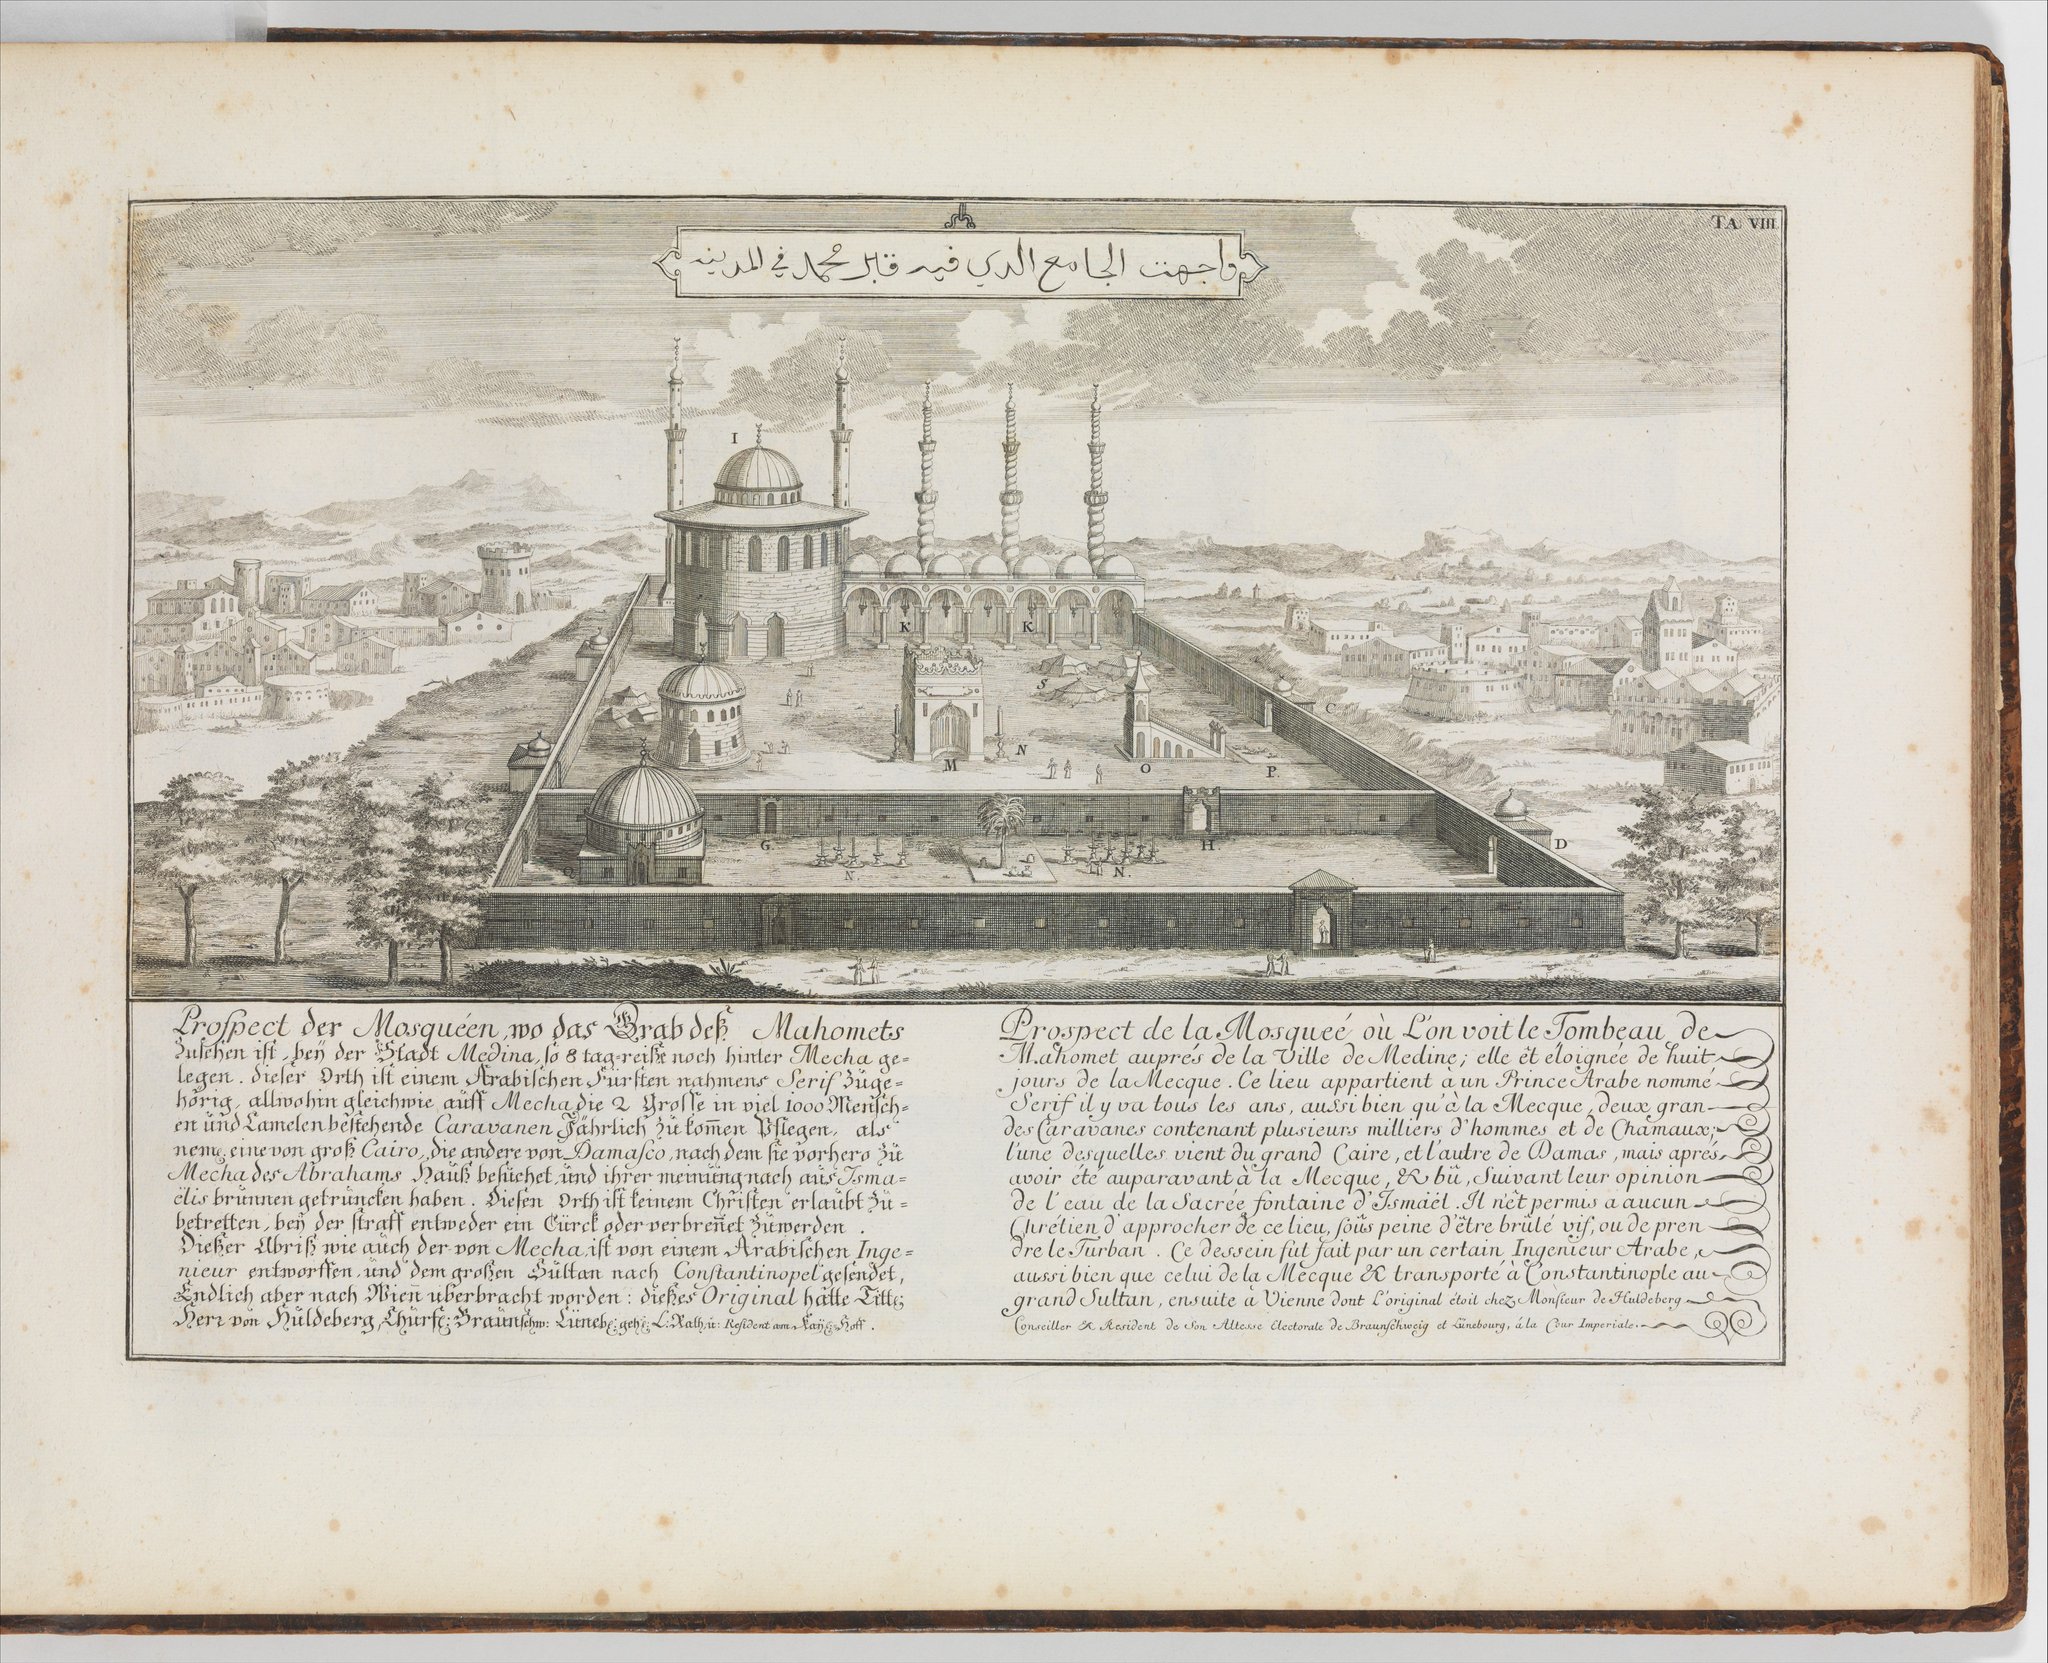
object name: book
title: Entwurff Einer Historischen Architectur (5 parts)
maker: johann bernhard fischer von erlach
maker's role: artist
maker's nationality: austrian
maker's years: 1656-1723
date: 1725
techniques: engraving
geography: germany